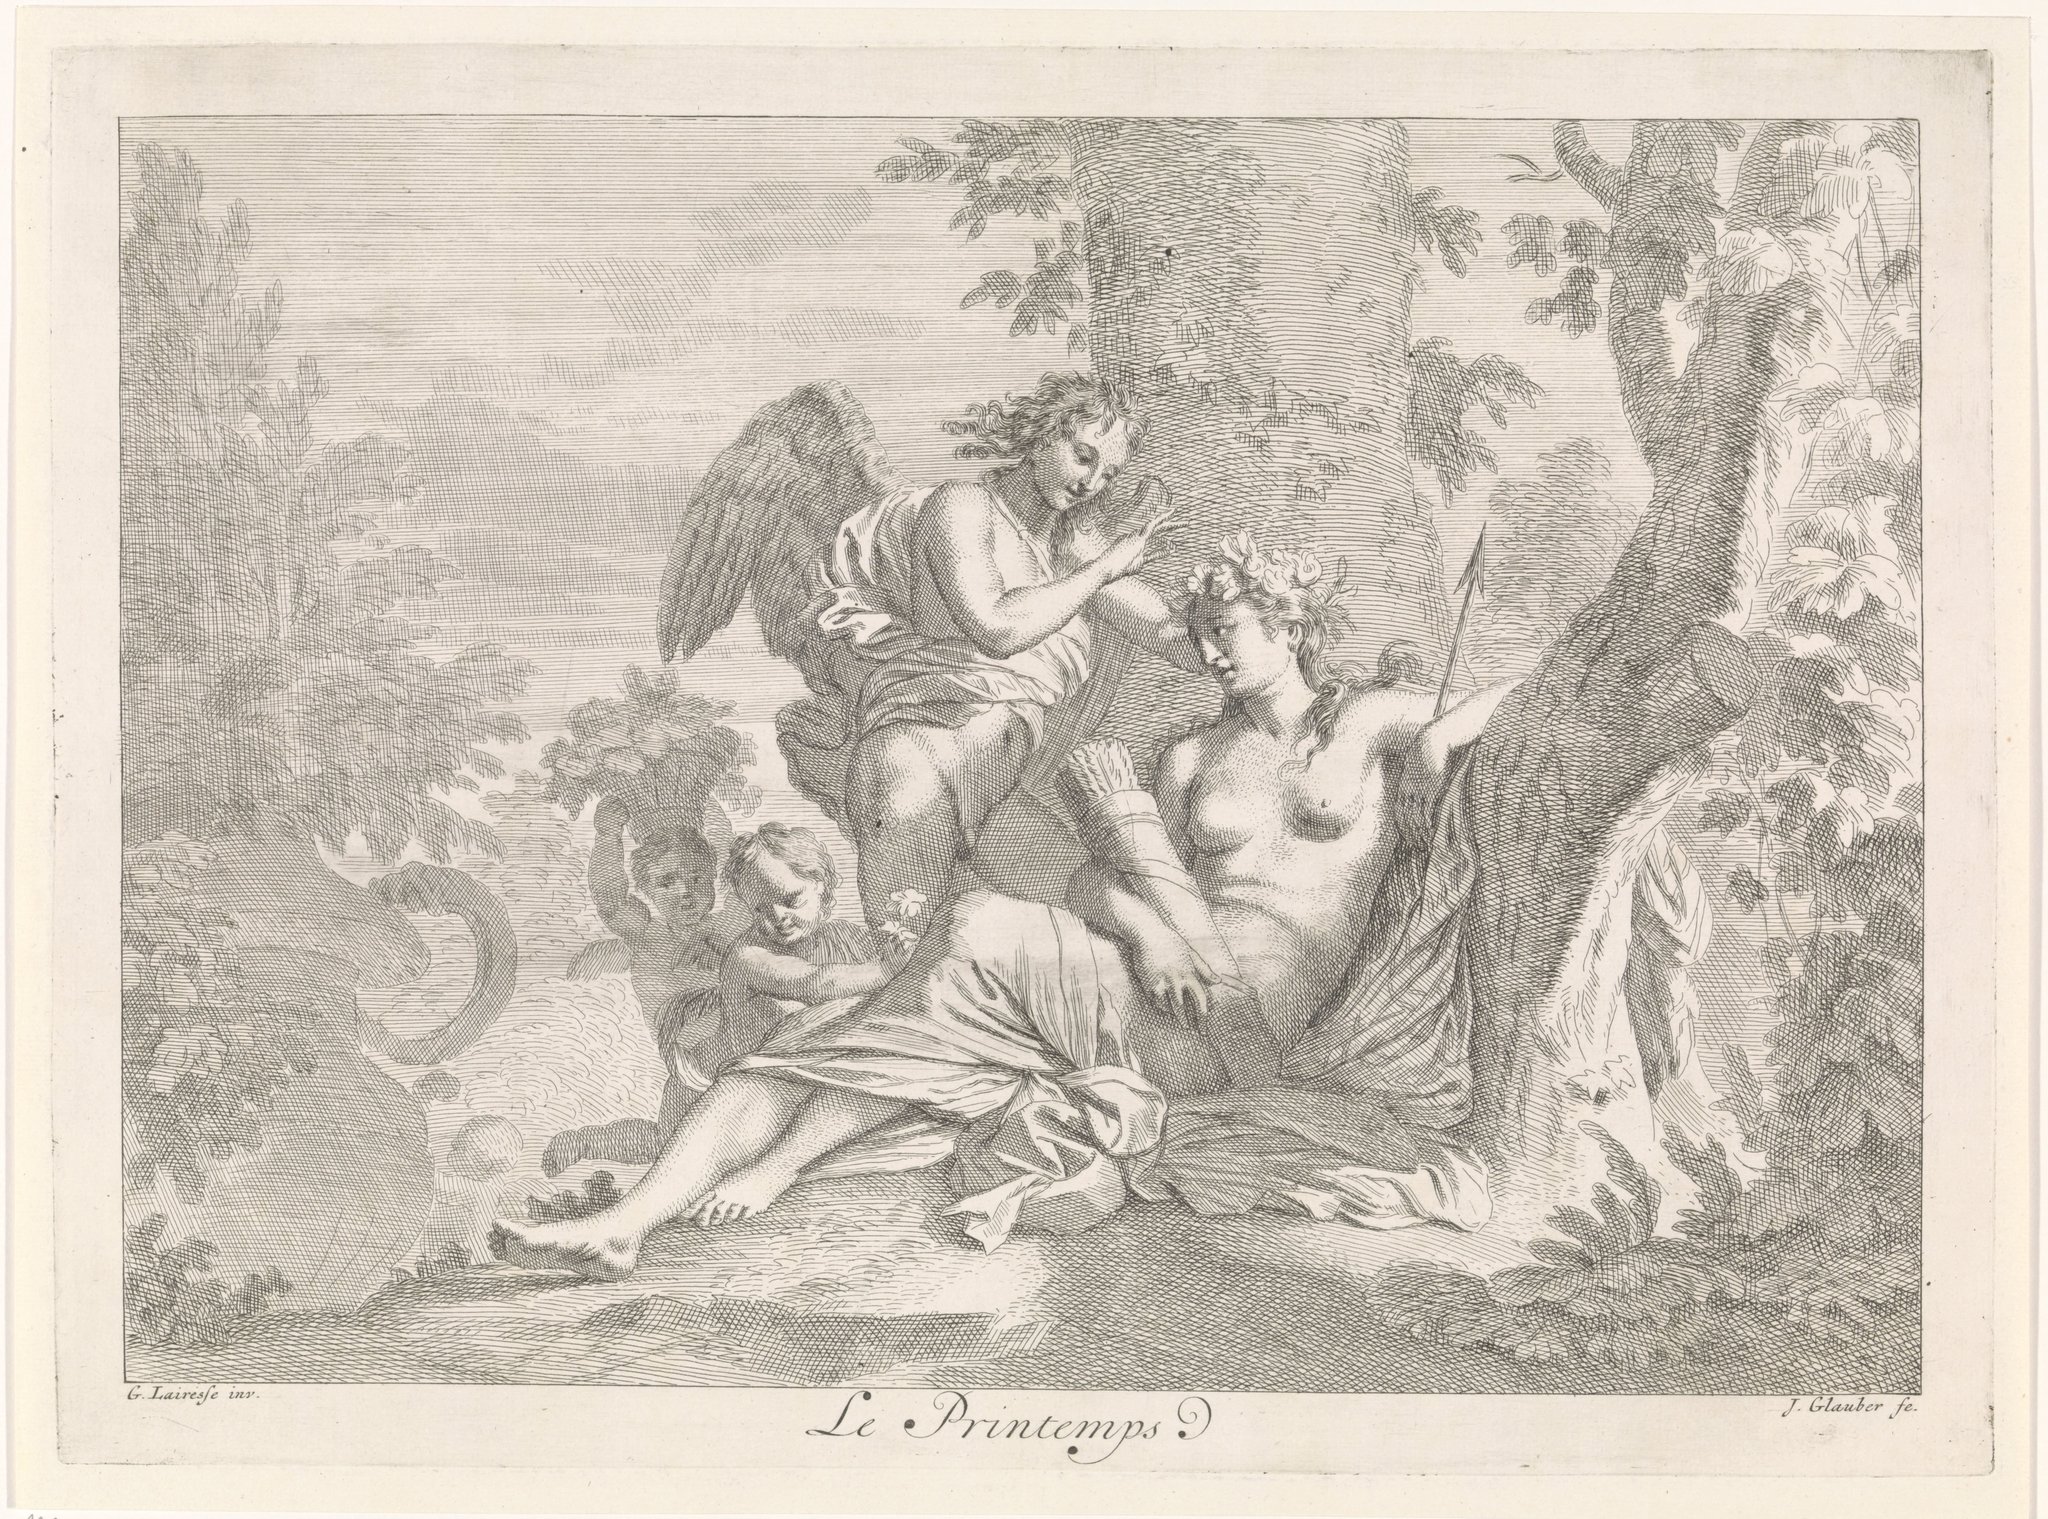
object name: print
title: Bijbelse, mythologische en allegorische voorstellingen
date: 1656-1726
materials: paper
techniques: etching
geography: amsterdam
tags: venus and cupid (cupid not being mere attribute), spring, 'ver'; 'primavera' (ripa) (+ with venus)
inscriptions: collector's mark: Lugt 2228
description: Venus ligt tegen een boom aangeleund. In haar handen een pijlenkoker. Cupido staat over haar gebogen en plukt bloemen van haar bloemenkroon. Ze worden omringd door twee putti. De prent maakt deel uit van een serie met Bijbelse, mythologische en allegorische voorstellingen.